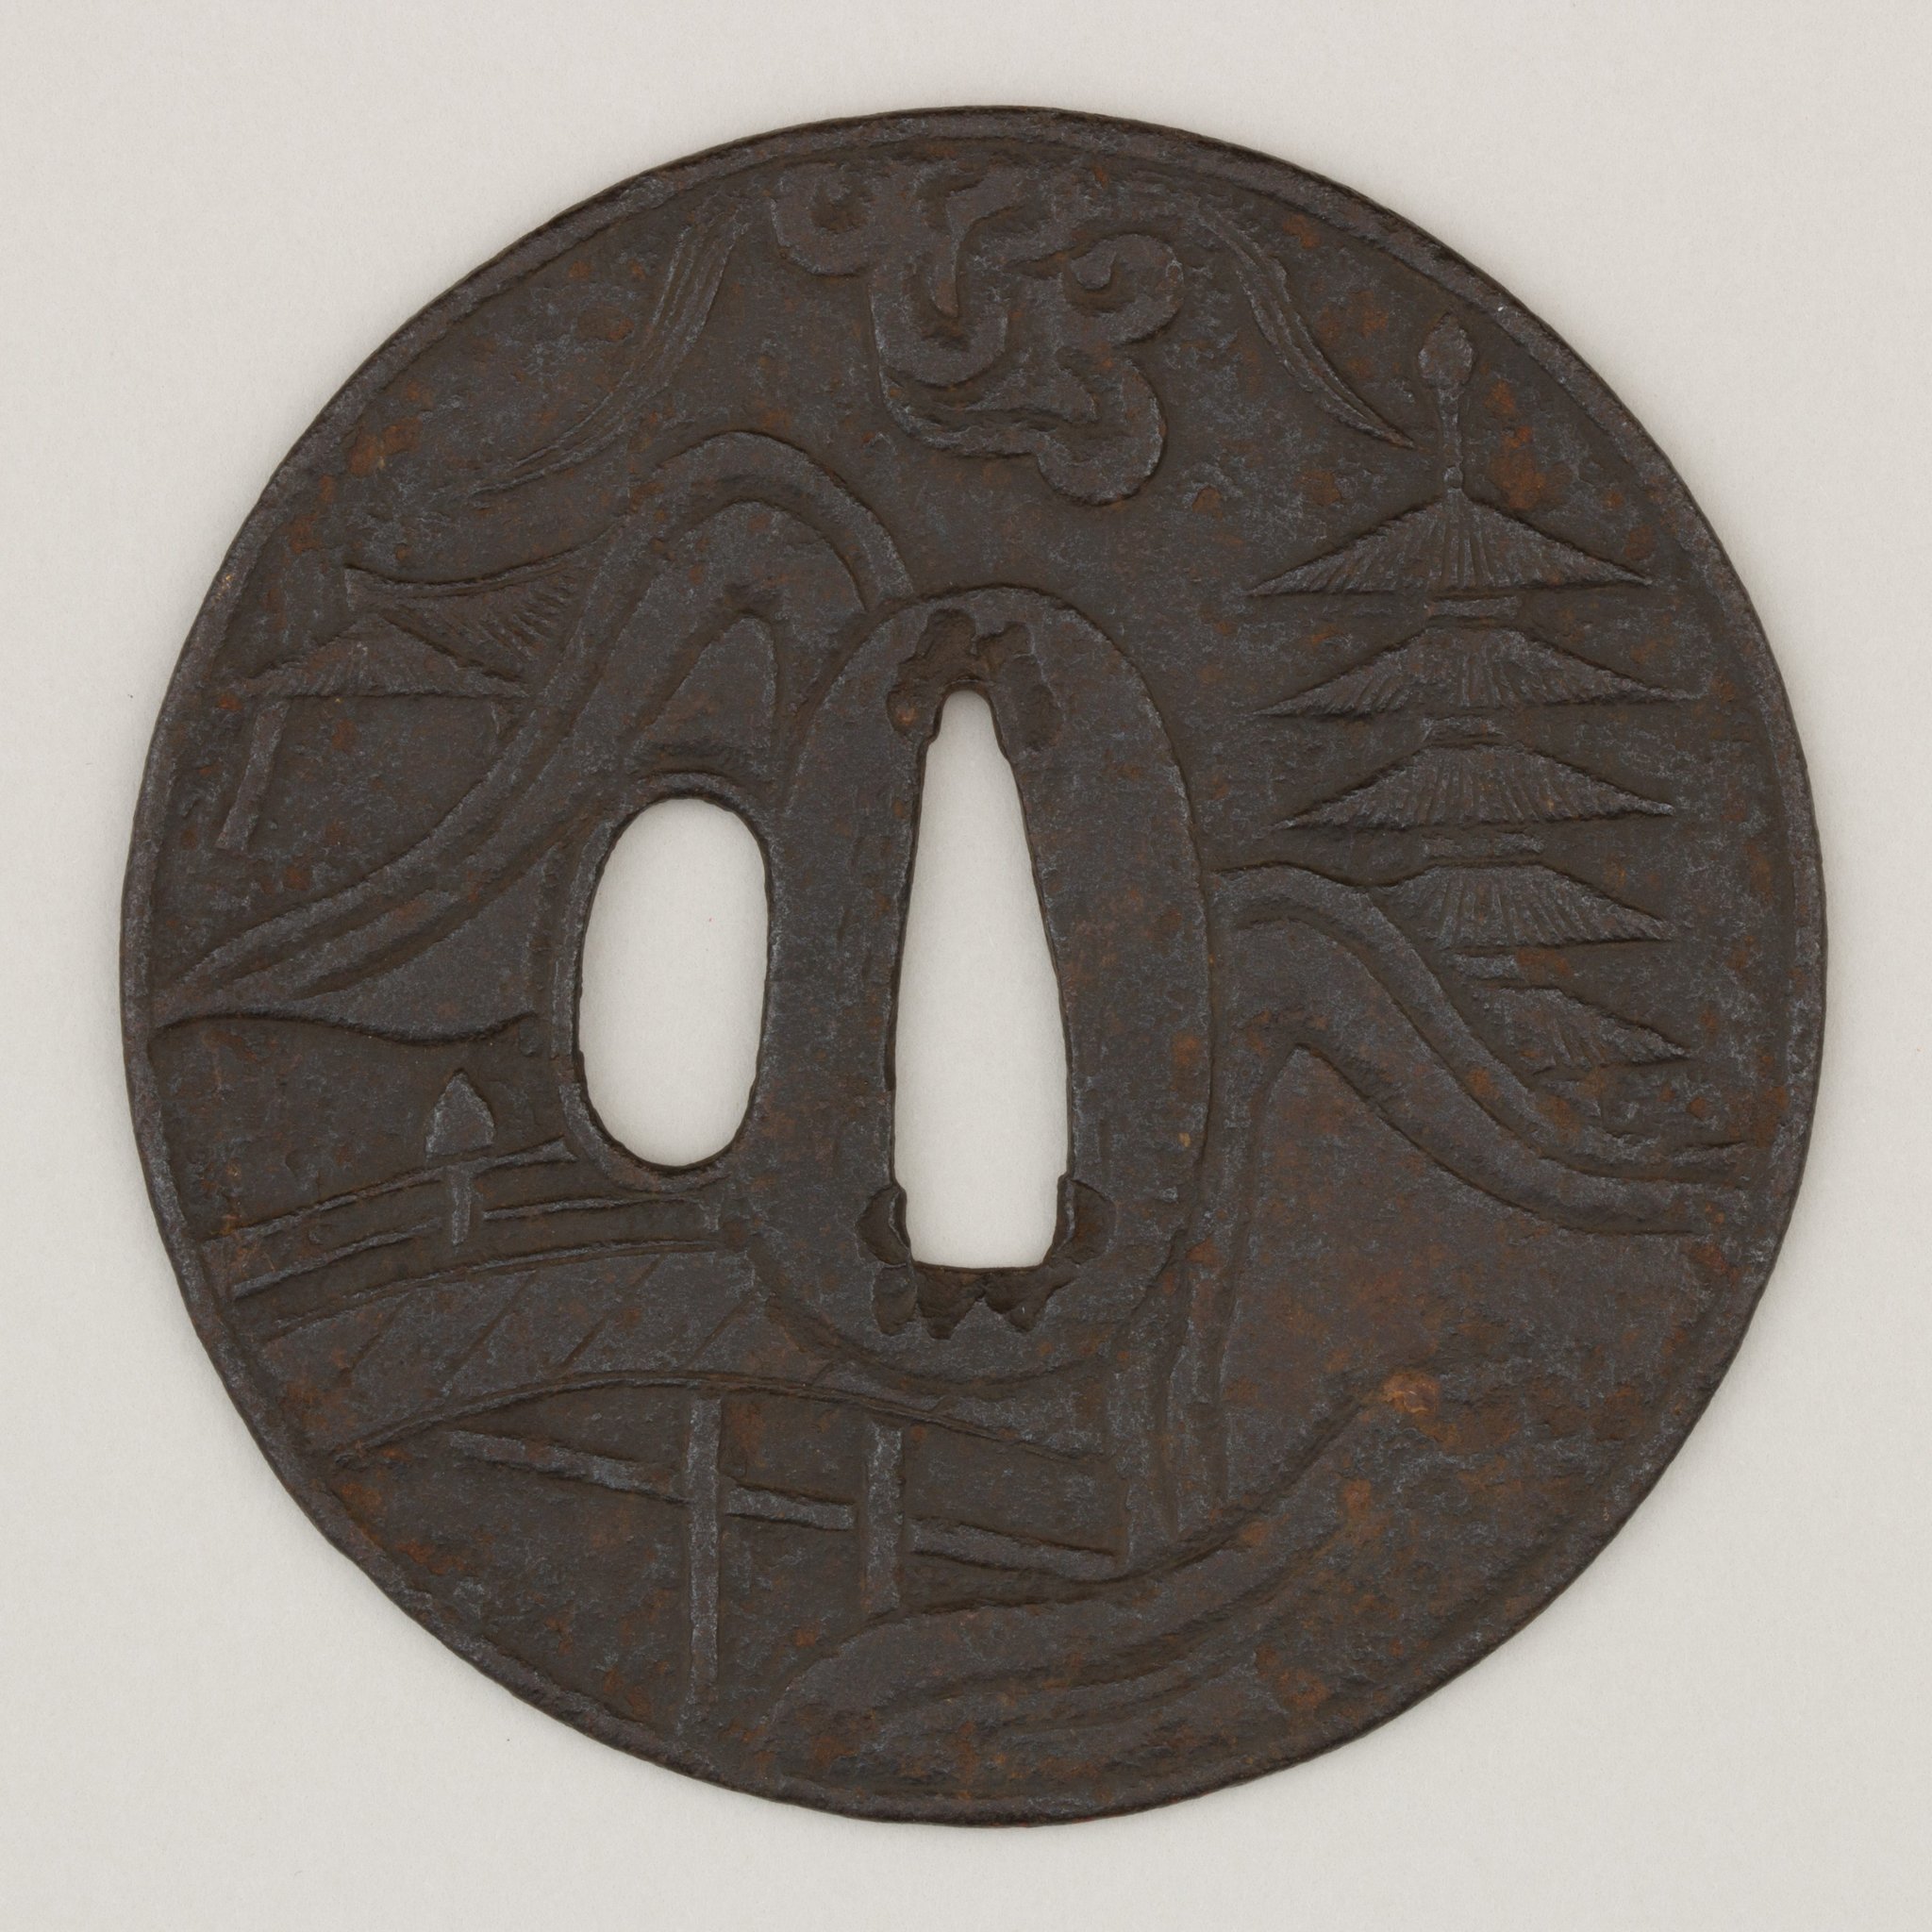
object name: sword guard tsuba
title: Sword Guard (Tsuba)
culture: japanese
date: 1601-1700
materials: copper, iron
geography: japan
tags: landscapes